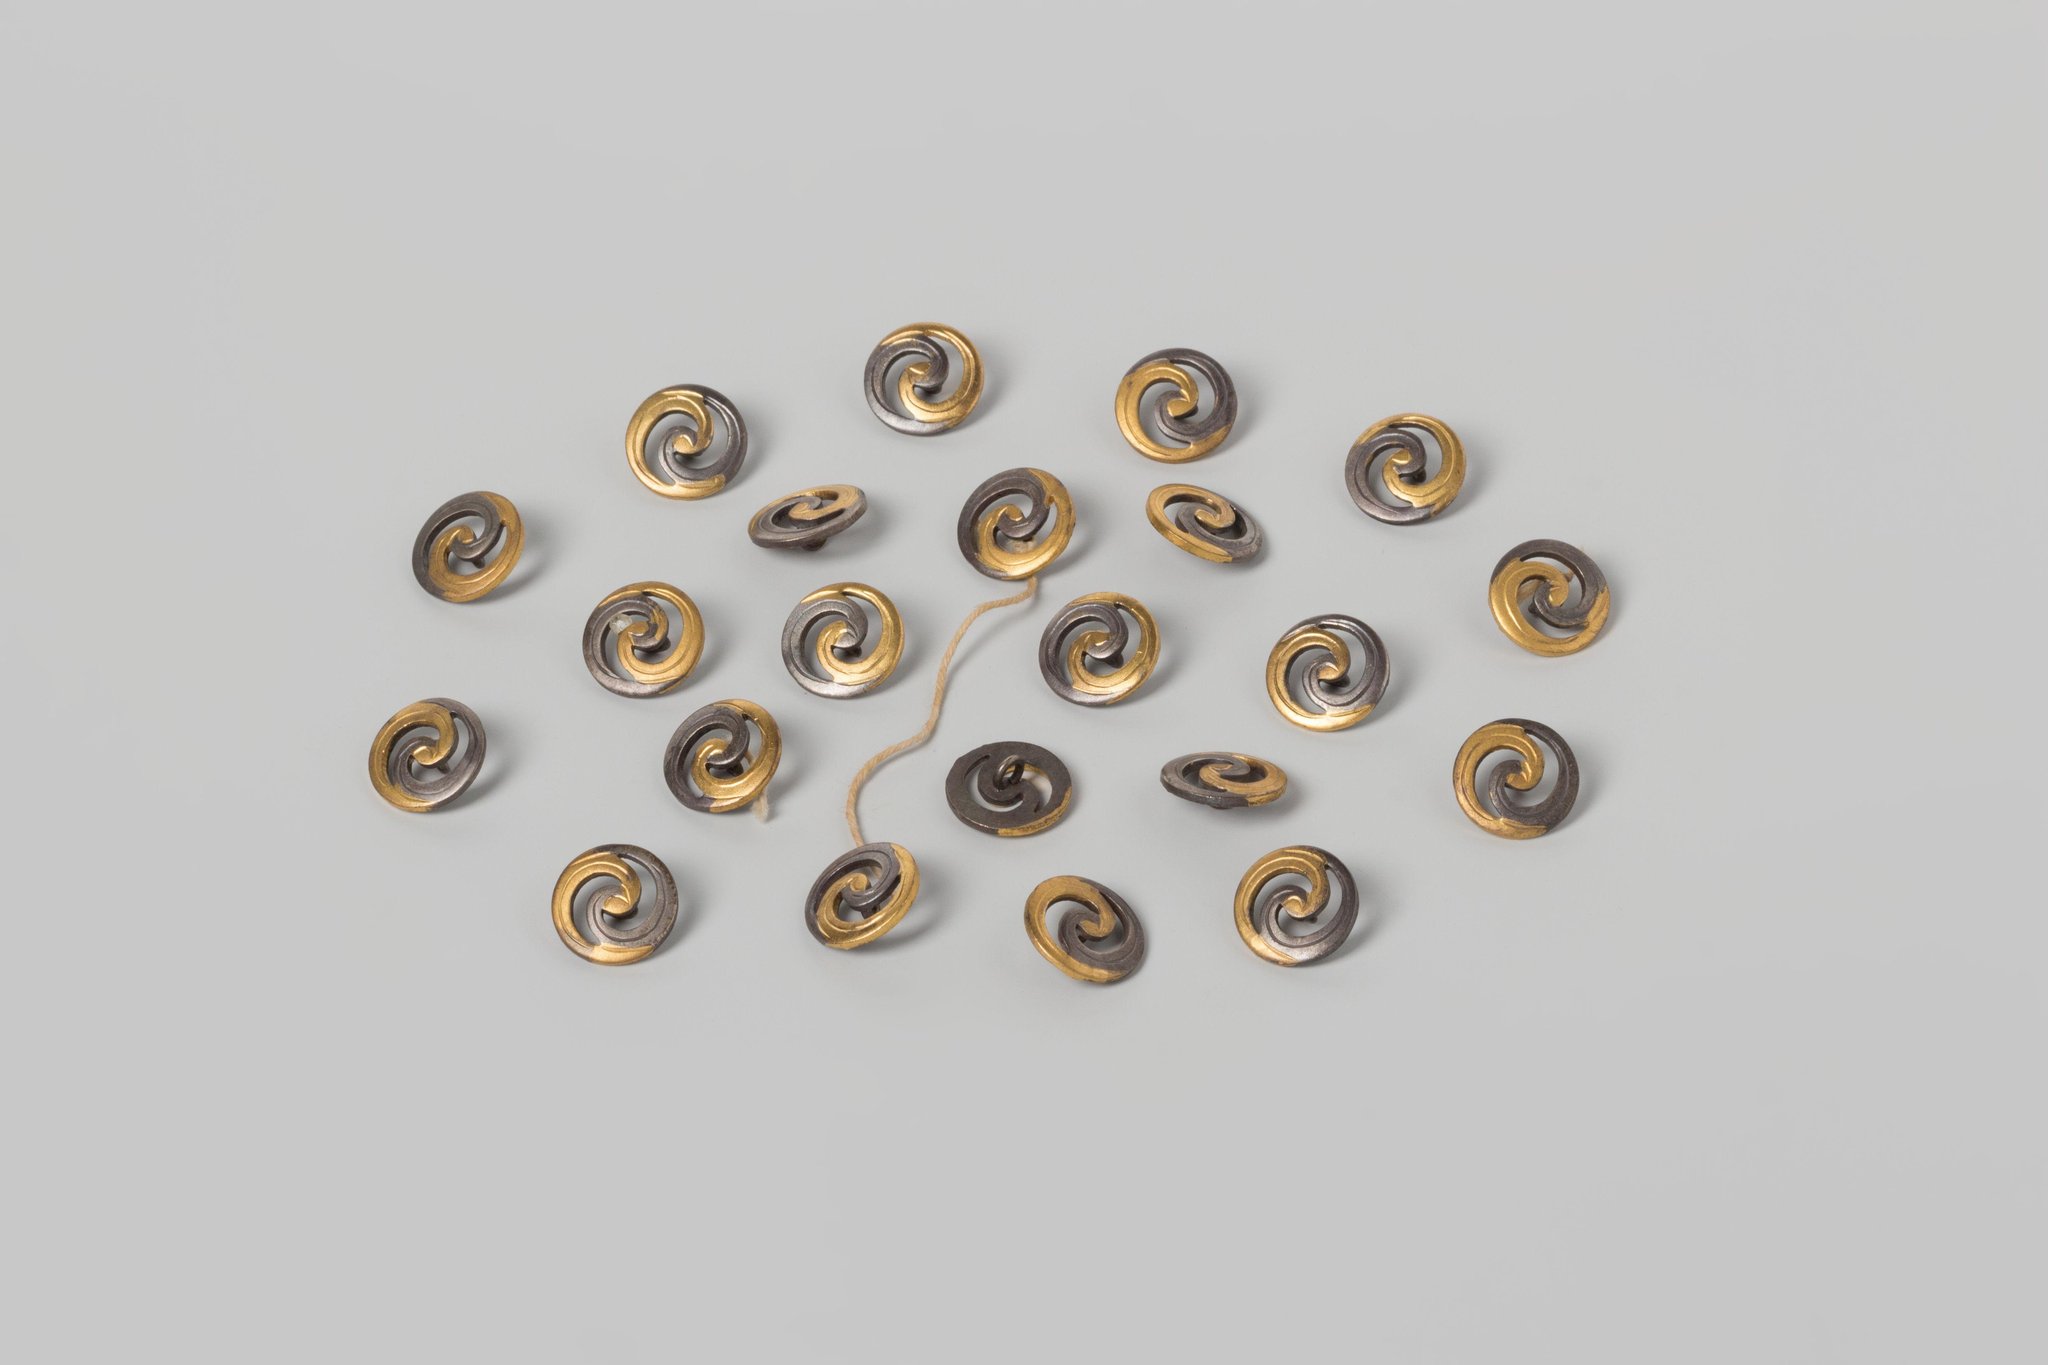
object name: clothing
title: Knoop, plat en rond, van gedeeltelijk met goudverf beschilderd metaal met krulmotief, gelijkend yin en yang, opengewerkt en gegraveerd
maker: Anonymous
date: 1880-1940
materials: paint, metal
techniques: embroidery, engraving, painting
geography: europe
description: Knoop, plat en rond, van gedeeltelijk met goudverf beschilderd metaal met krulmotief, gelijkend yin en yang, opengewerkt en gegraveerd.